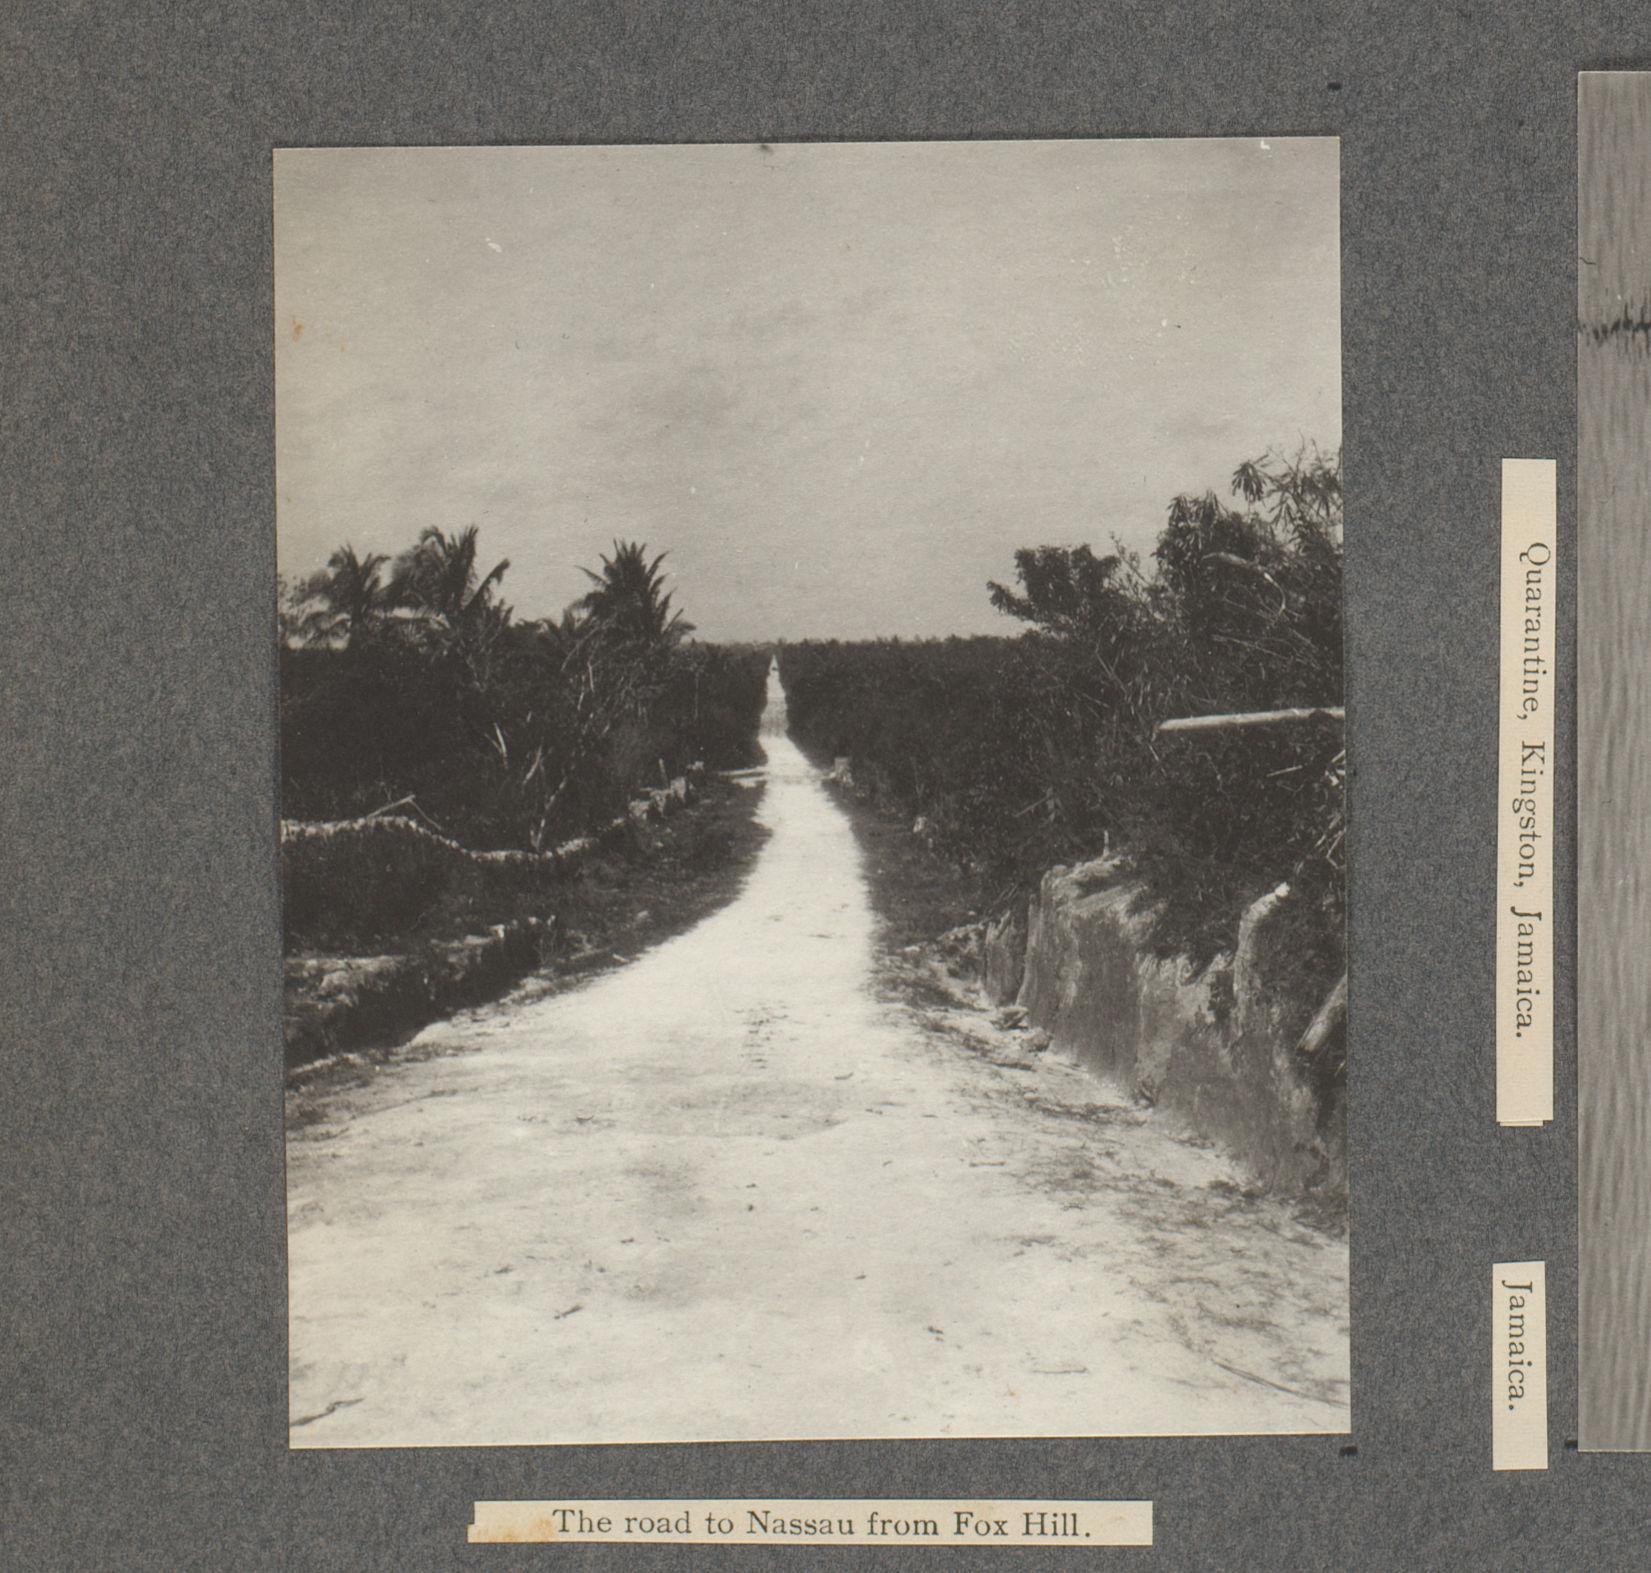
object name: album leaf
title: Weg tussen Nassau en Fox Hill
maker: Anonymous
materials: paper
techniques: platinum process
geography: bahamas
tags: road, path